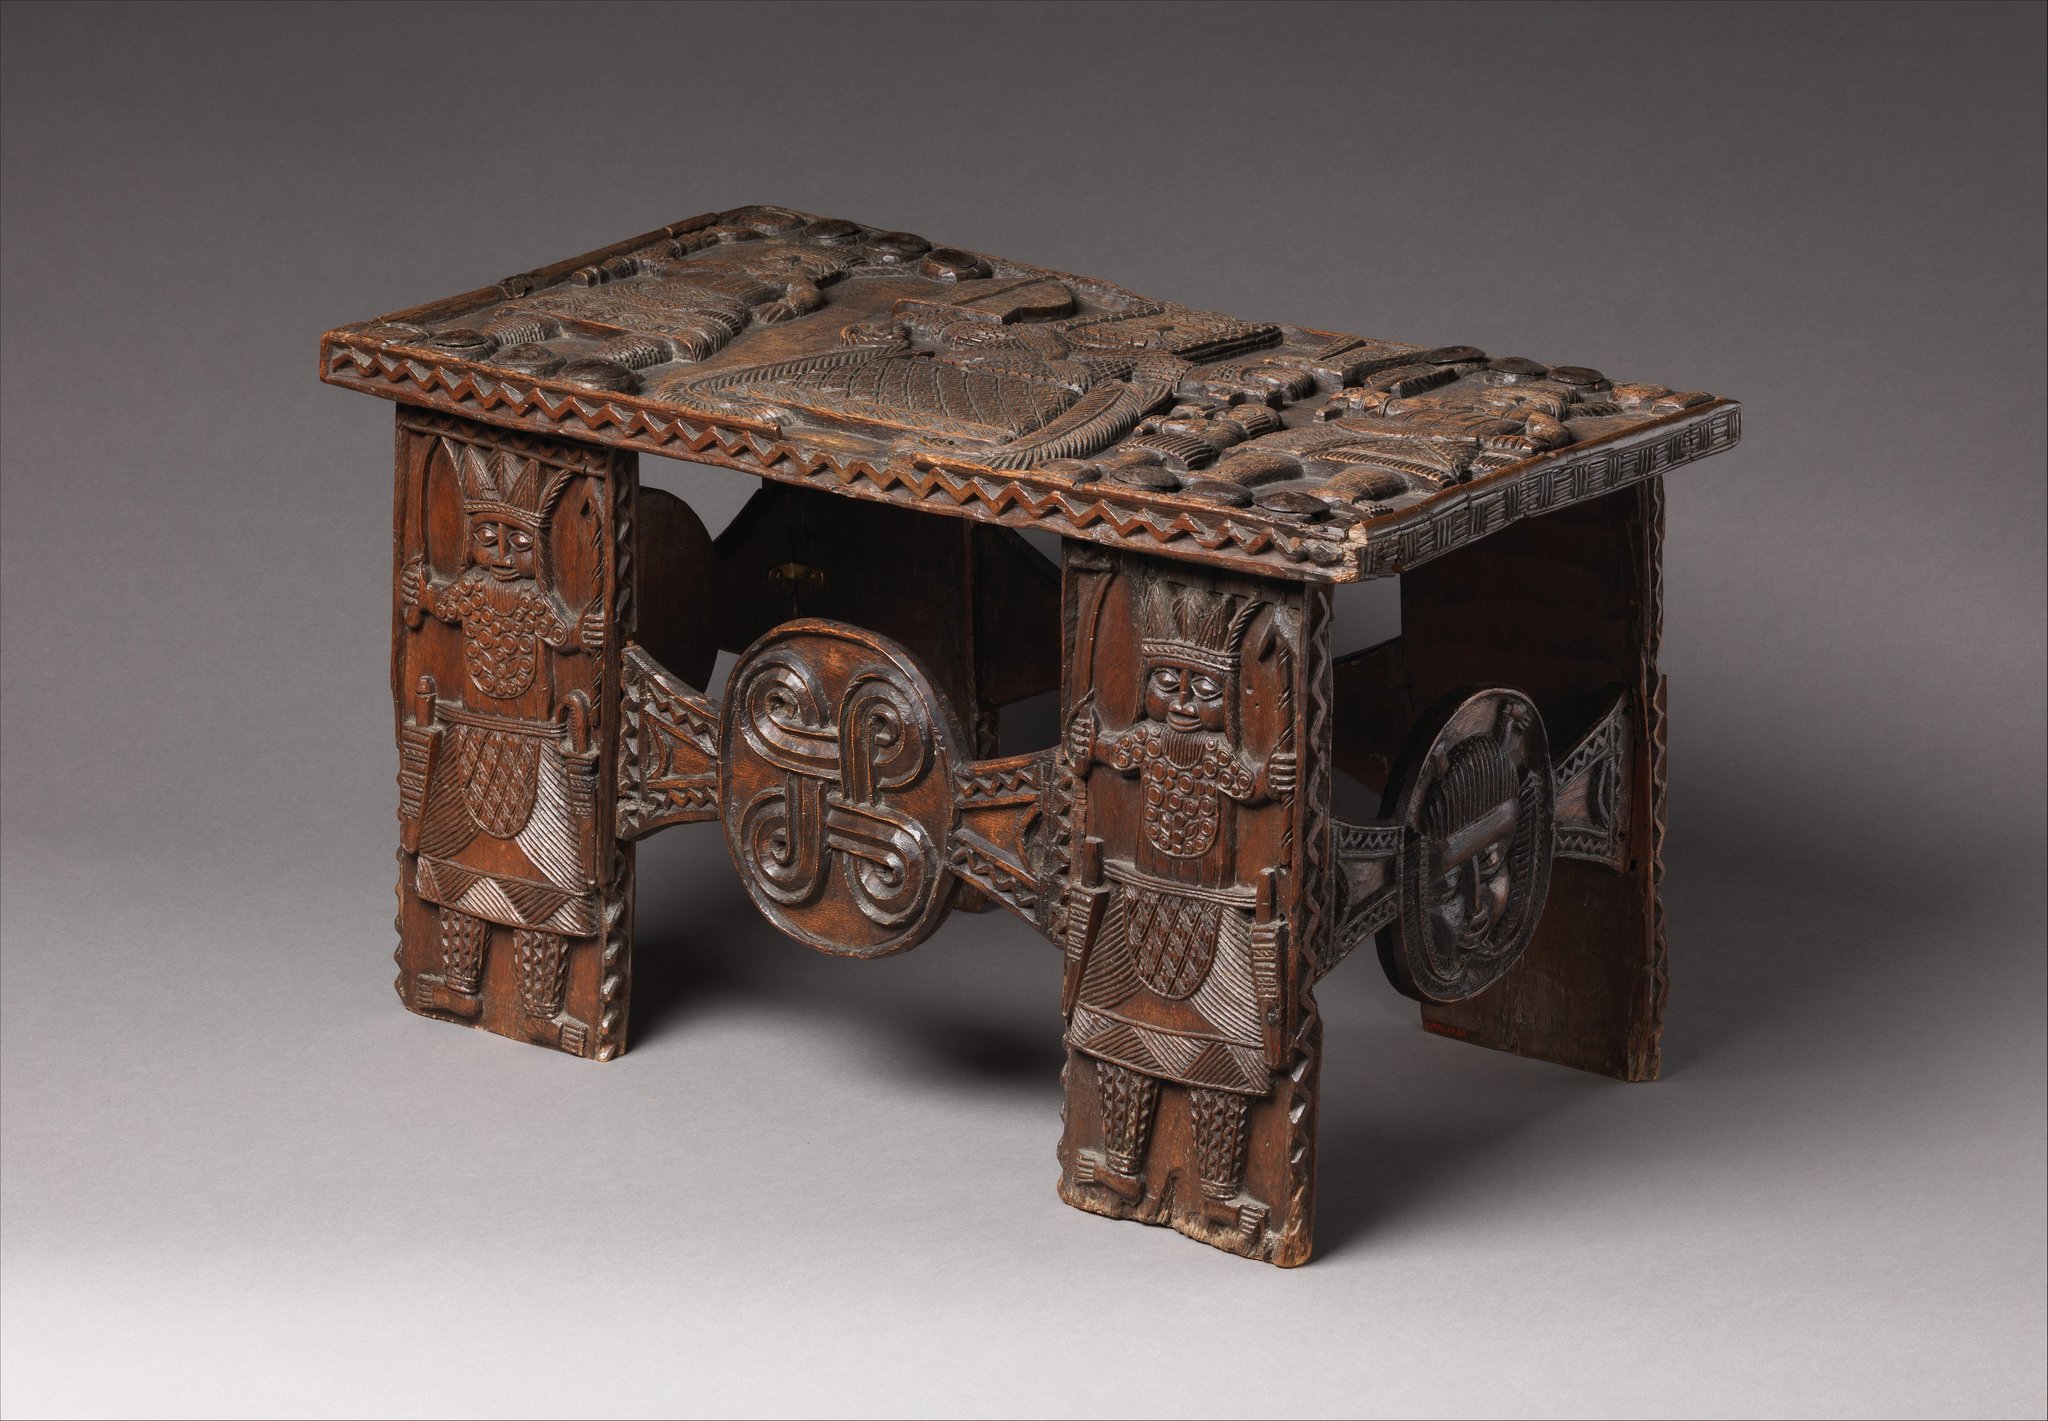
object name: stool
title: Stool: Oba with Mudfish Legs (Agba)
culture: edo period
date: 1867-1900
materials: metal, wood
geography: nigeria